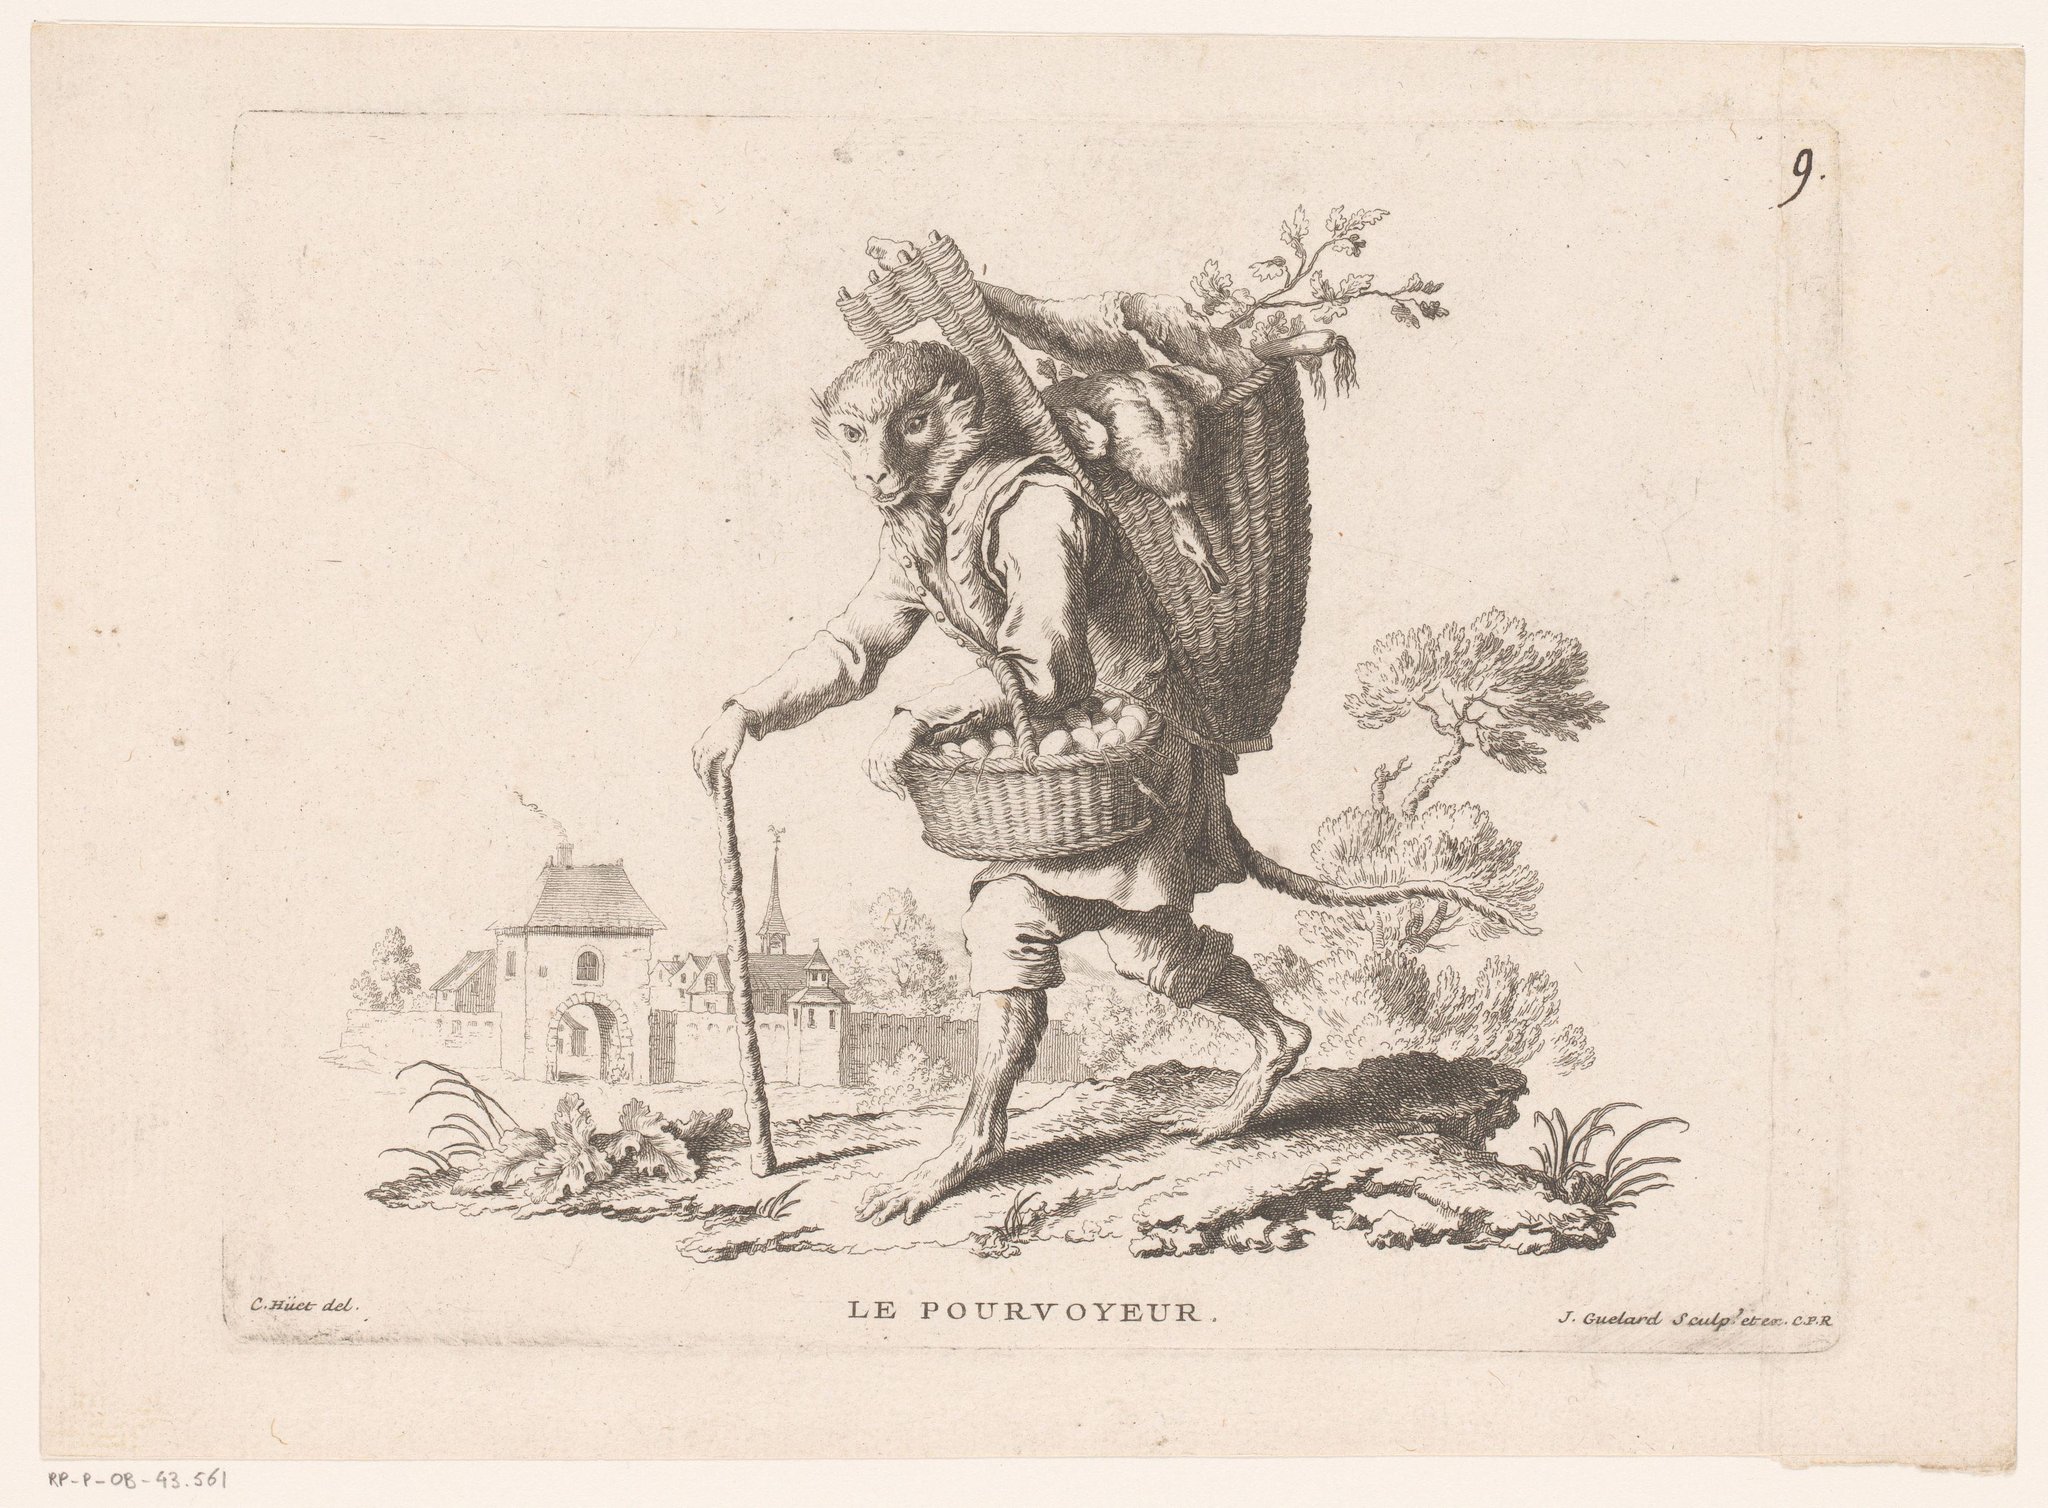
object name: print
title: Marskramer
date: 1733-1792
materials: paper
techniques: etching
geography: paris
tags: monkeys, apes, animals acting as human beings, merchant, salesman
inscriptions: collector's mark: Lugt 2228, number: ‘9.’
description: Maakt waarschijnlijk deel uit van een twaalfdelige serie getiteld 'Singeries ou differentes Actions de la Vie humaine', met apenspelen. De serie bestaat uit twee delen met elk twaalf platen en een opdracht. Deze serie is opgedragen aan het publiek (Au Public). Het andere deel werd opgedragen aan Monsieur de l'Orme van de Ménagerie de Versailles. De serie werd initieel uitgegeven door Guélard en de weduwe van Chéreau. Dit betreft waarschijnlijk een door het IFF onbeschreven latere staat, uitgegeven door Étienne Charpentier.